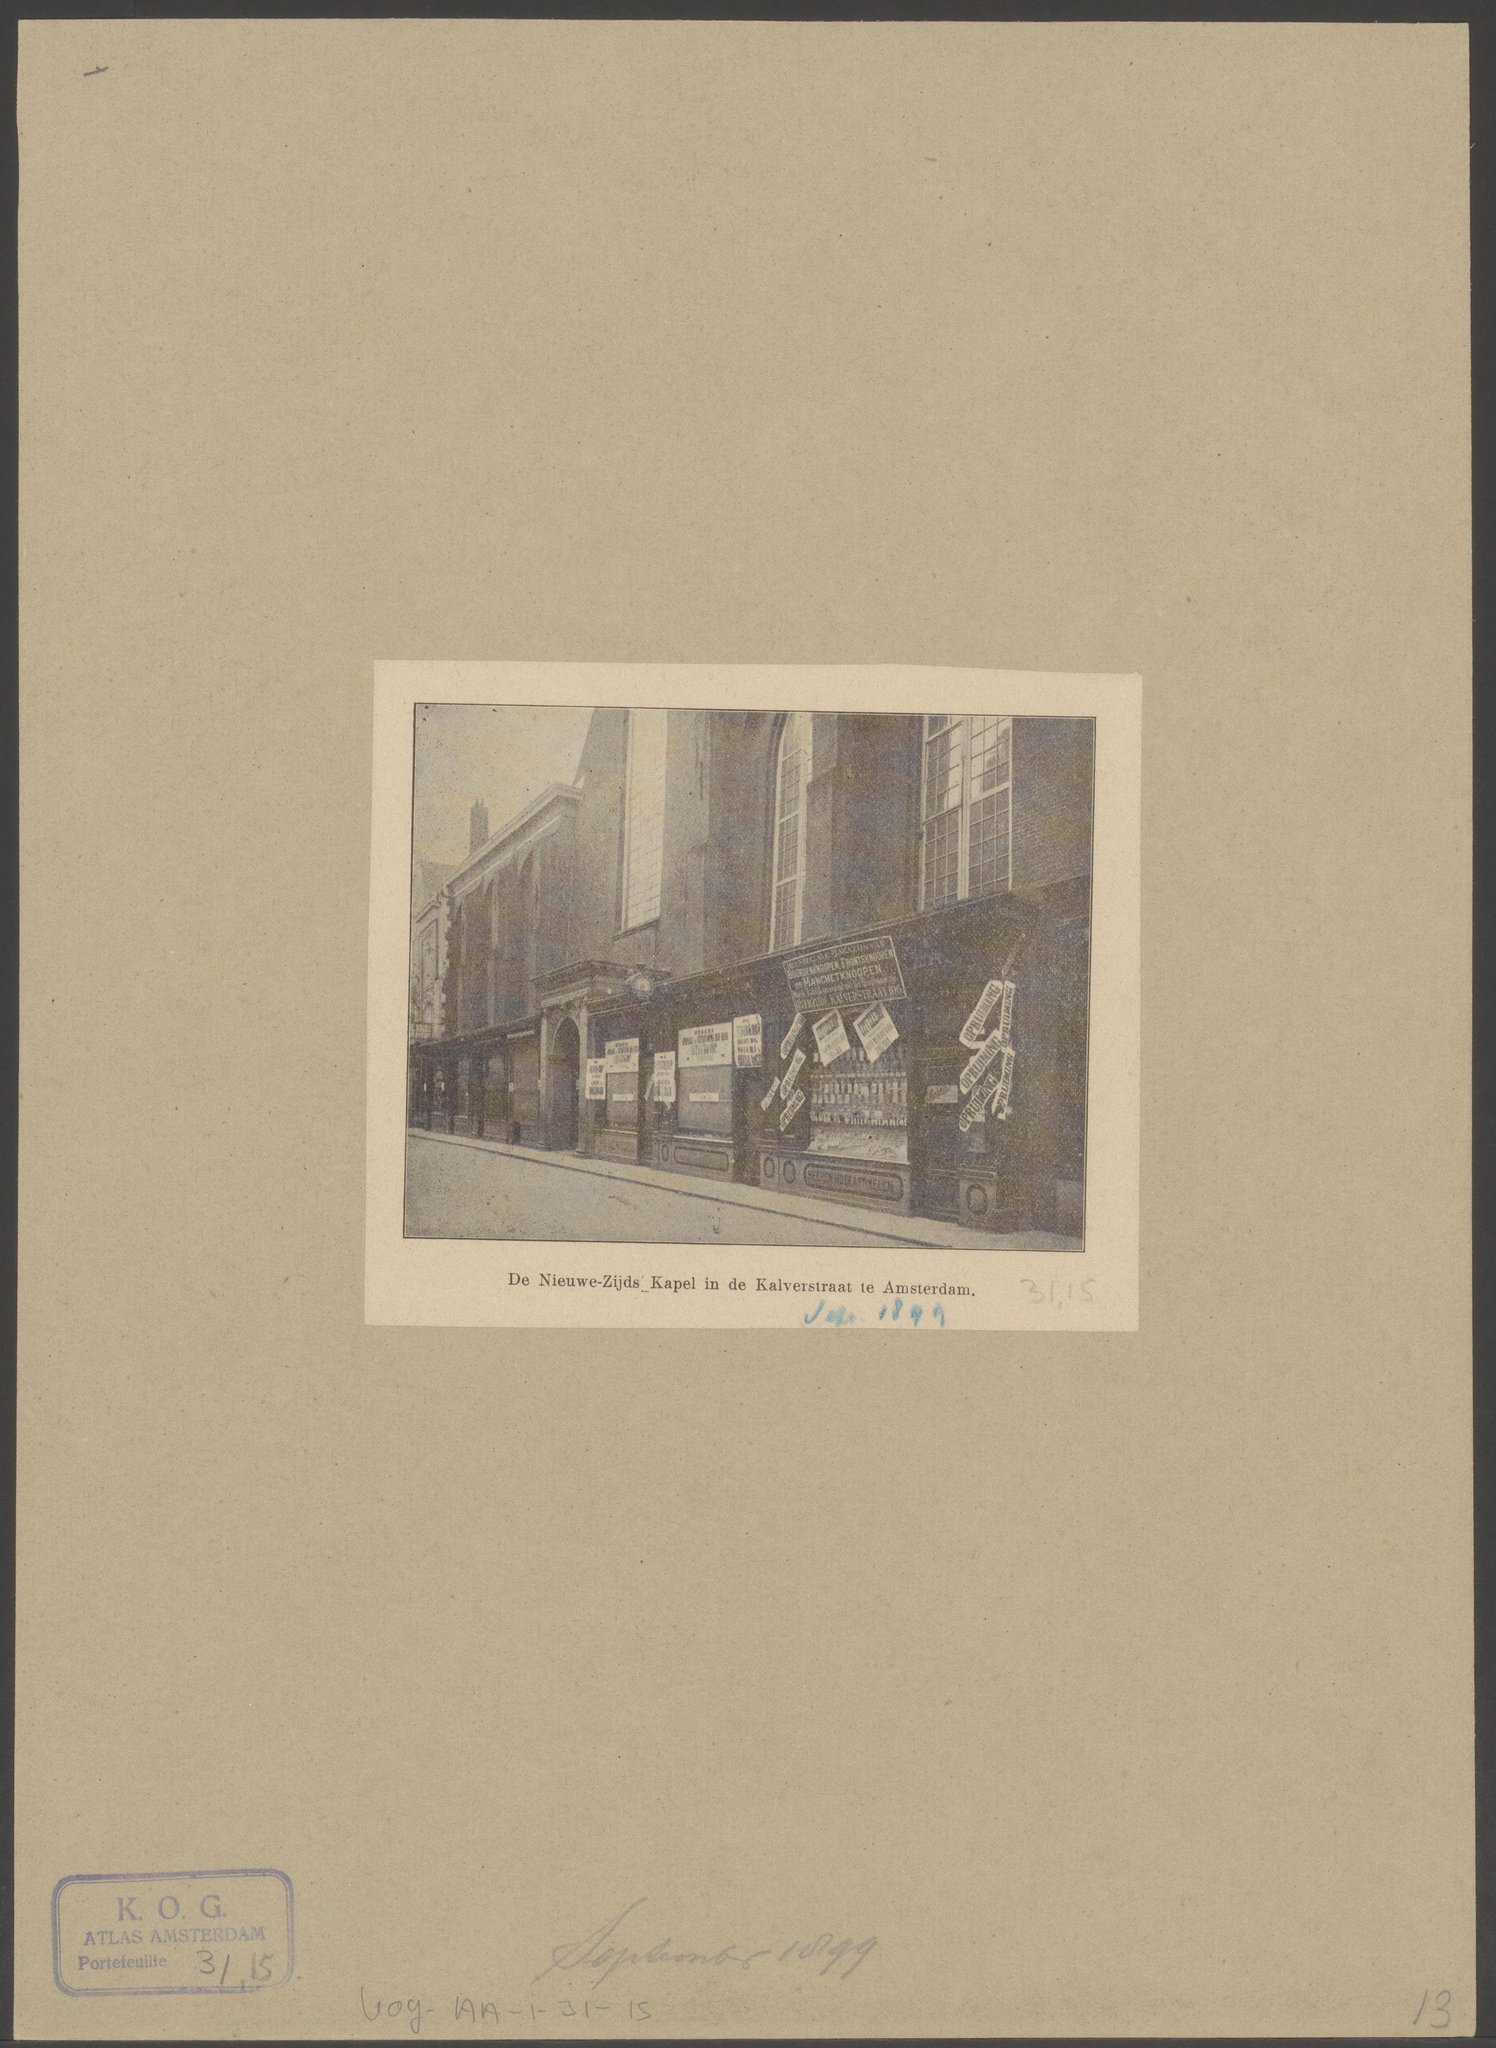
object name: photomechanical print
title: Winkels aan de Nieuwezijds Kapel te Amsterdam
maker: Anonymous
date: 1809-1899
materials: paper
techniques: letterpress printing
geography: netherlands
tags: shop, store, church (exterior) - qq - small church, chapel, street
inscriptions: collector's mark: Lugt 1641b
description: Onderwerpsrubriek binnen de Atlas Amsterdam: Kerkwezen: Hervormde Gemeente: Nieuwezijds Kapel.